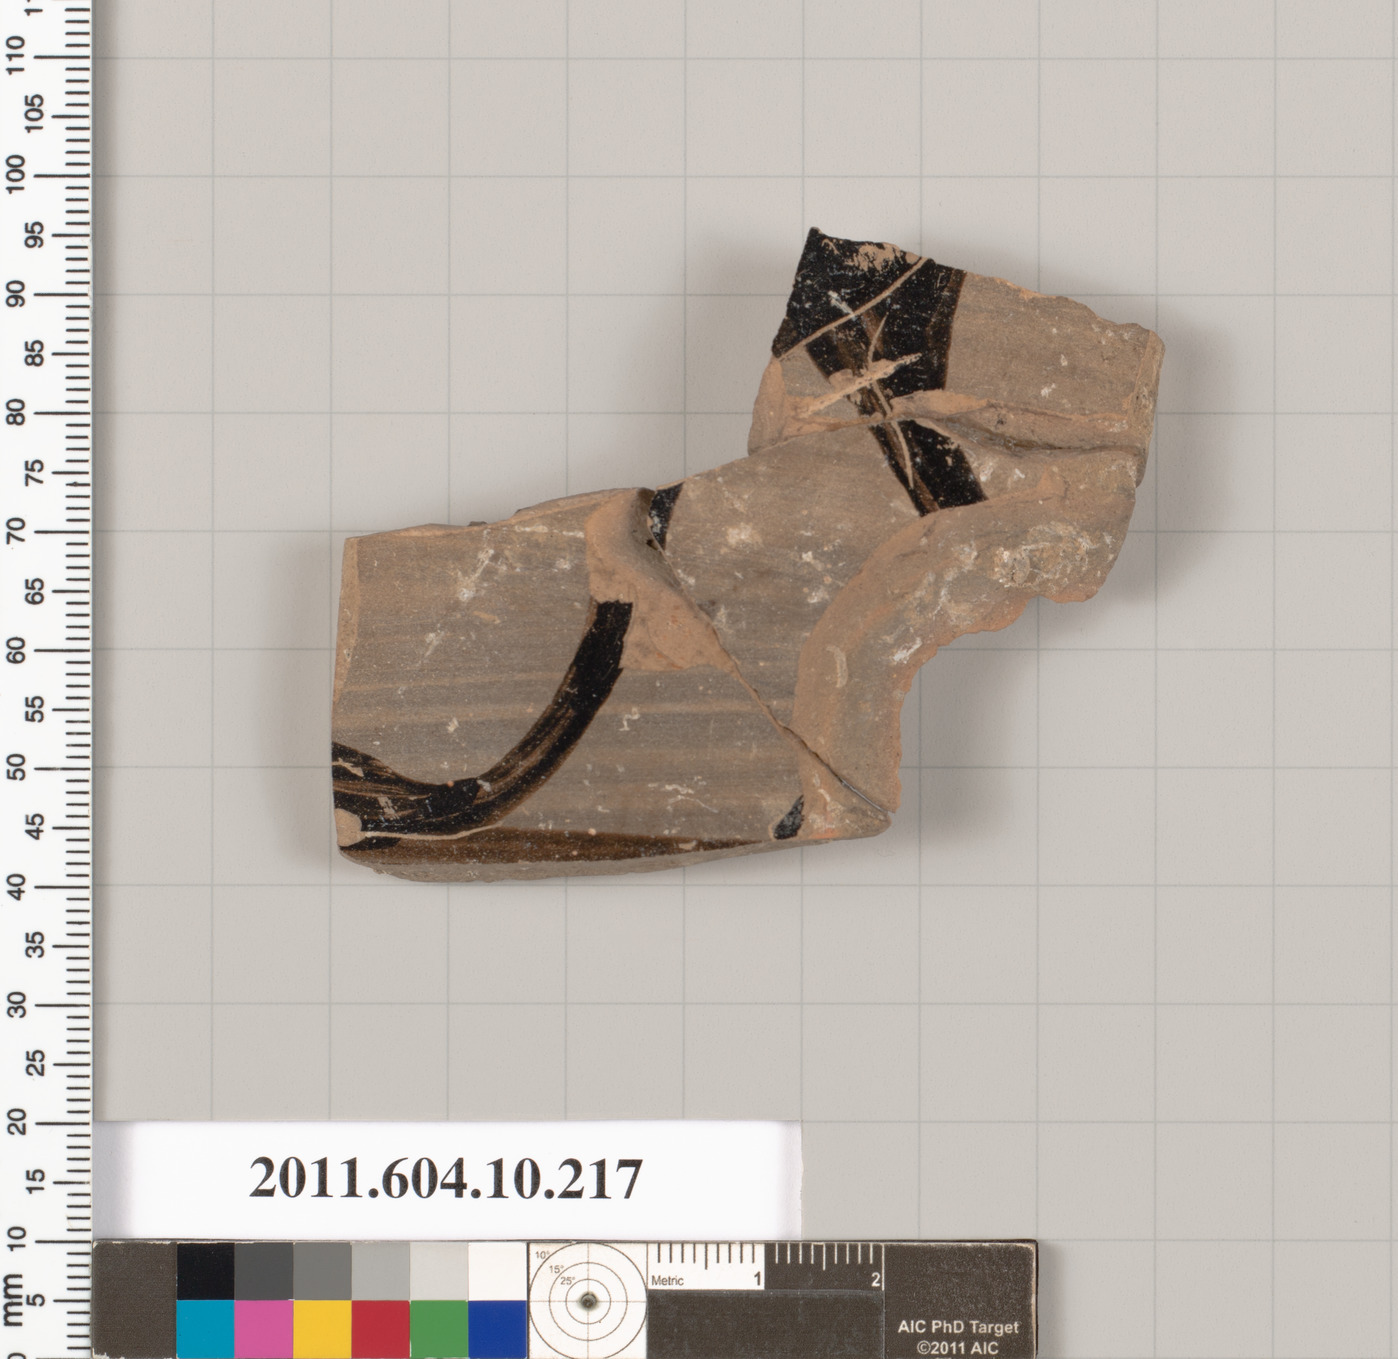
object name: amphora fragment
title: Terracotta fragment of an amphora (jar)?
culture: etruscan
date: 600-501 BCE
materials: terracotta